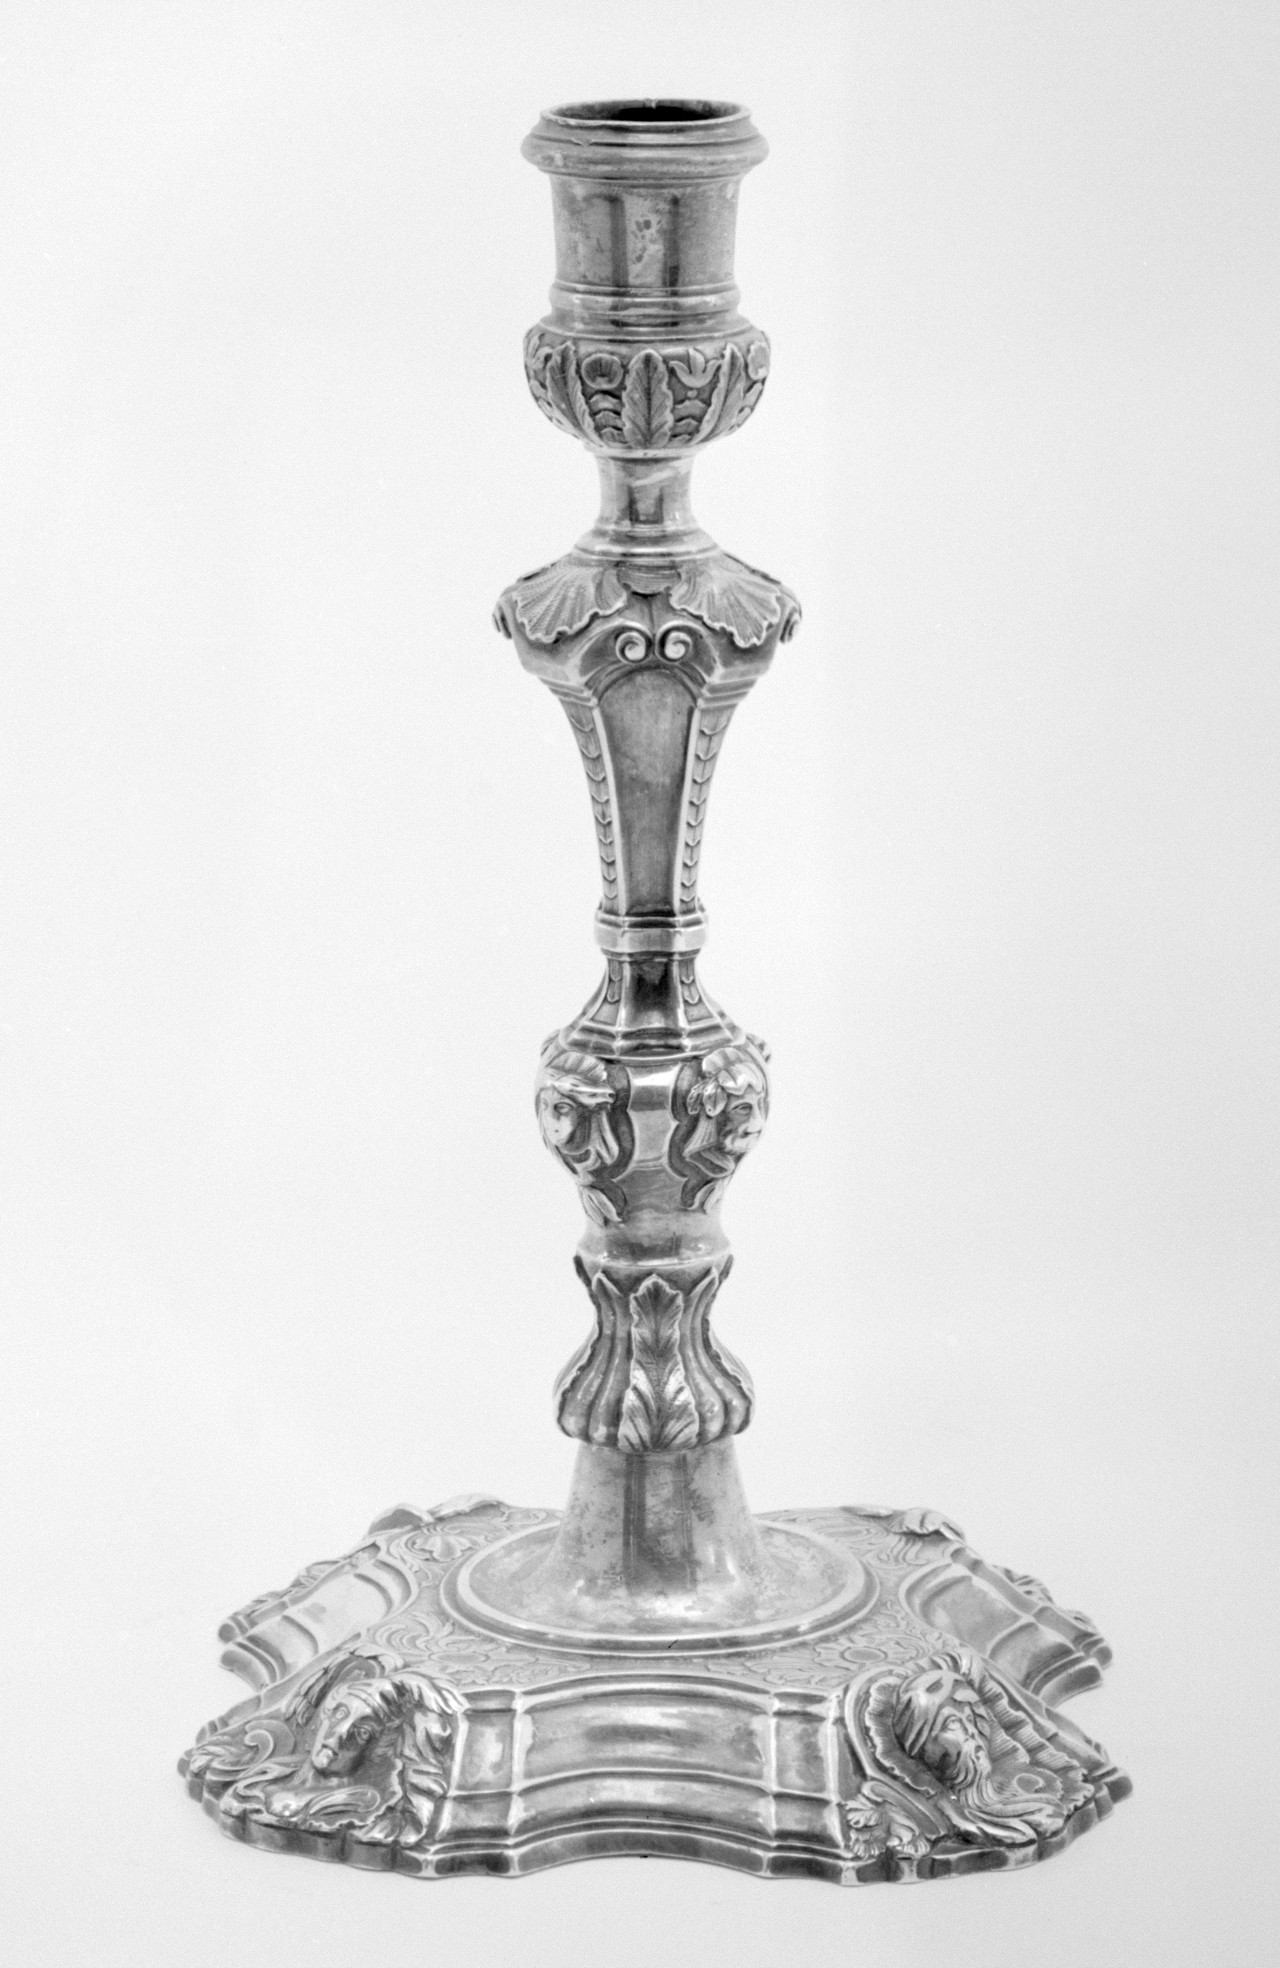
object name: candlestick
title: Pair of candlesticks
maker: robert calderwood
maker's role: maker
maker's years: 1665-1765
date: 1735-1740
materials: silver